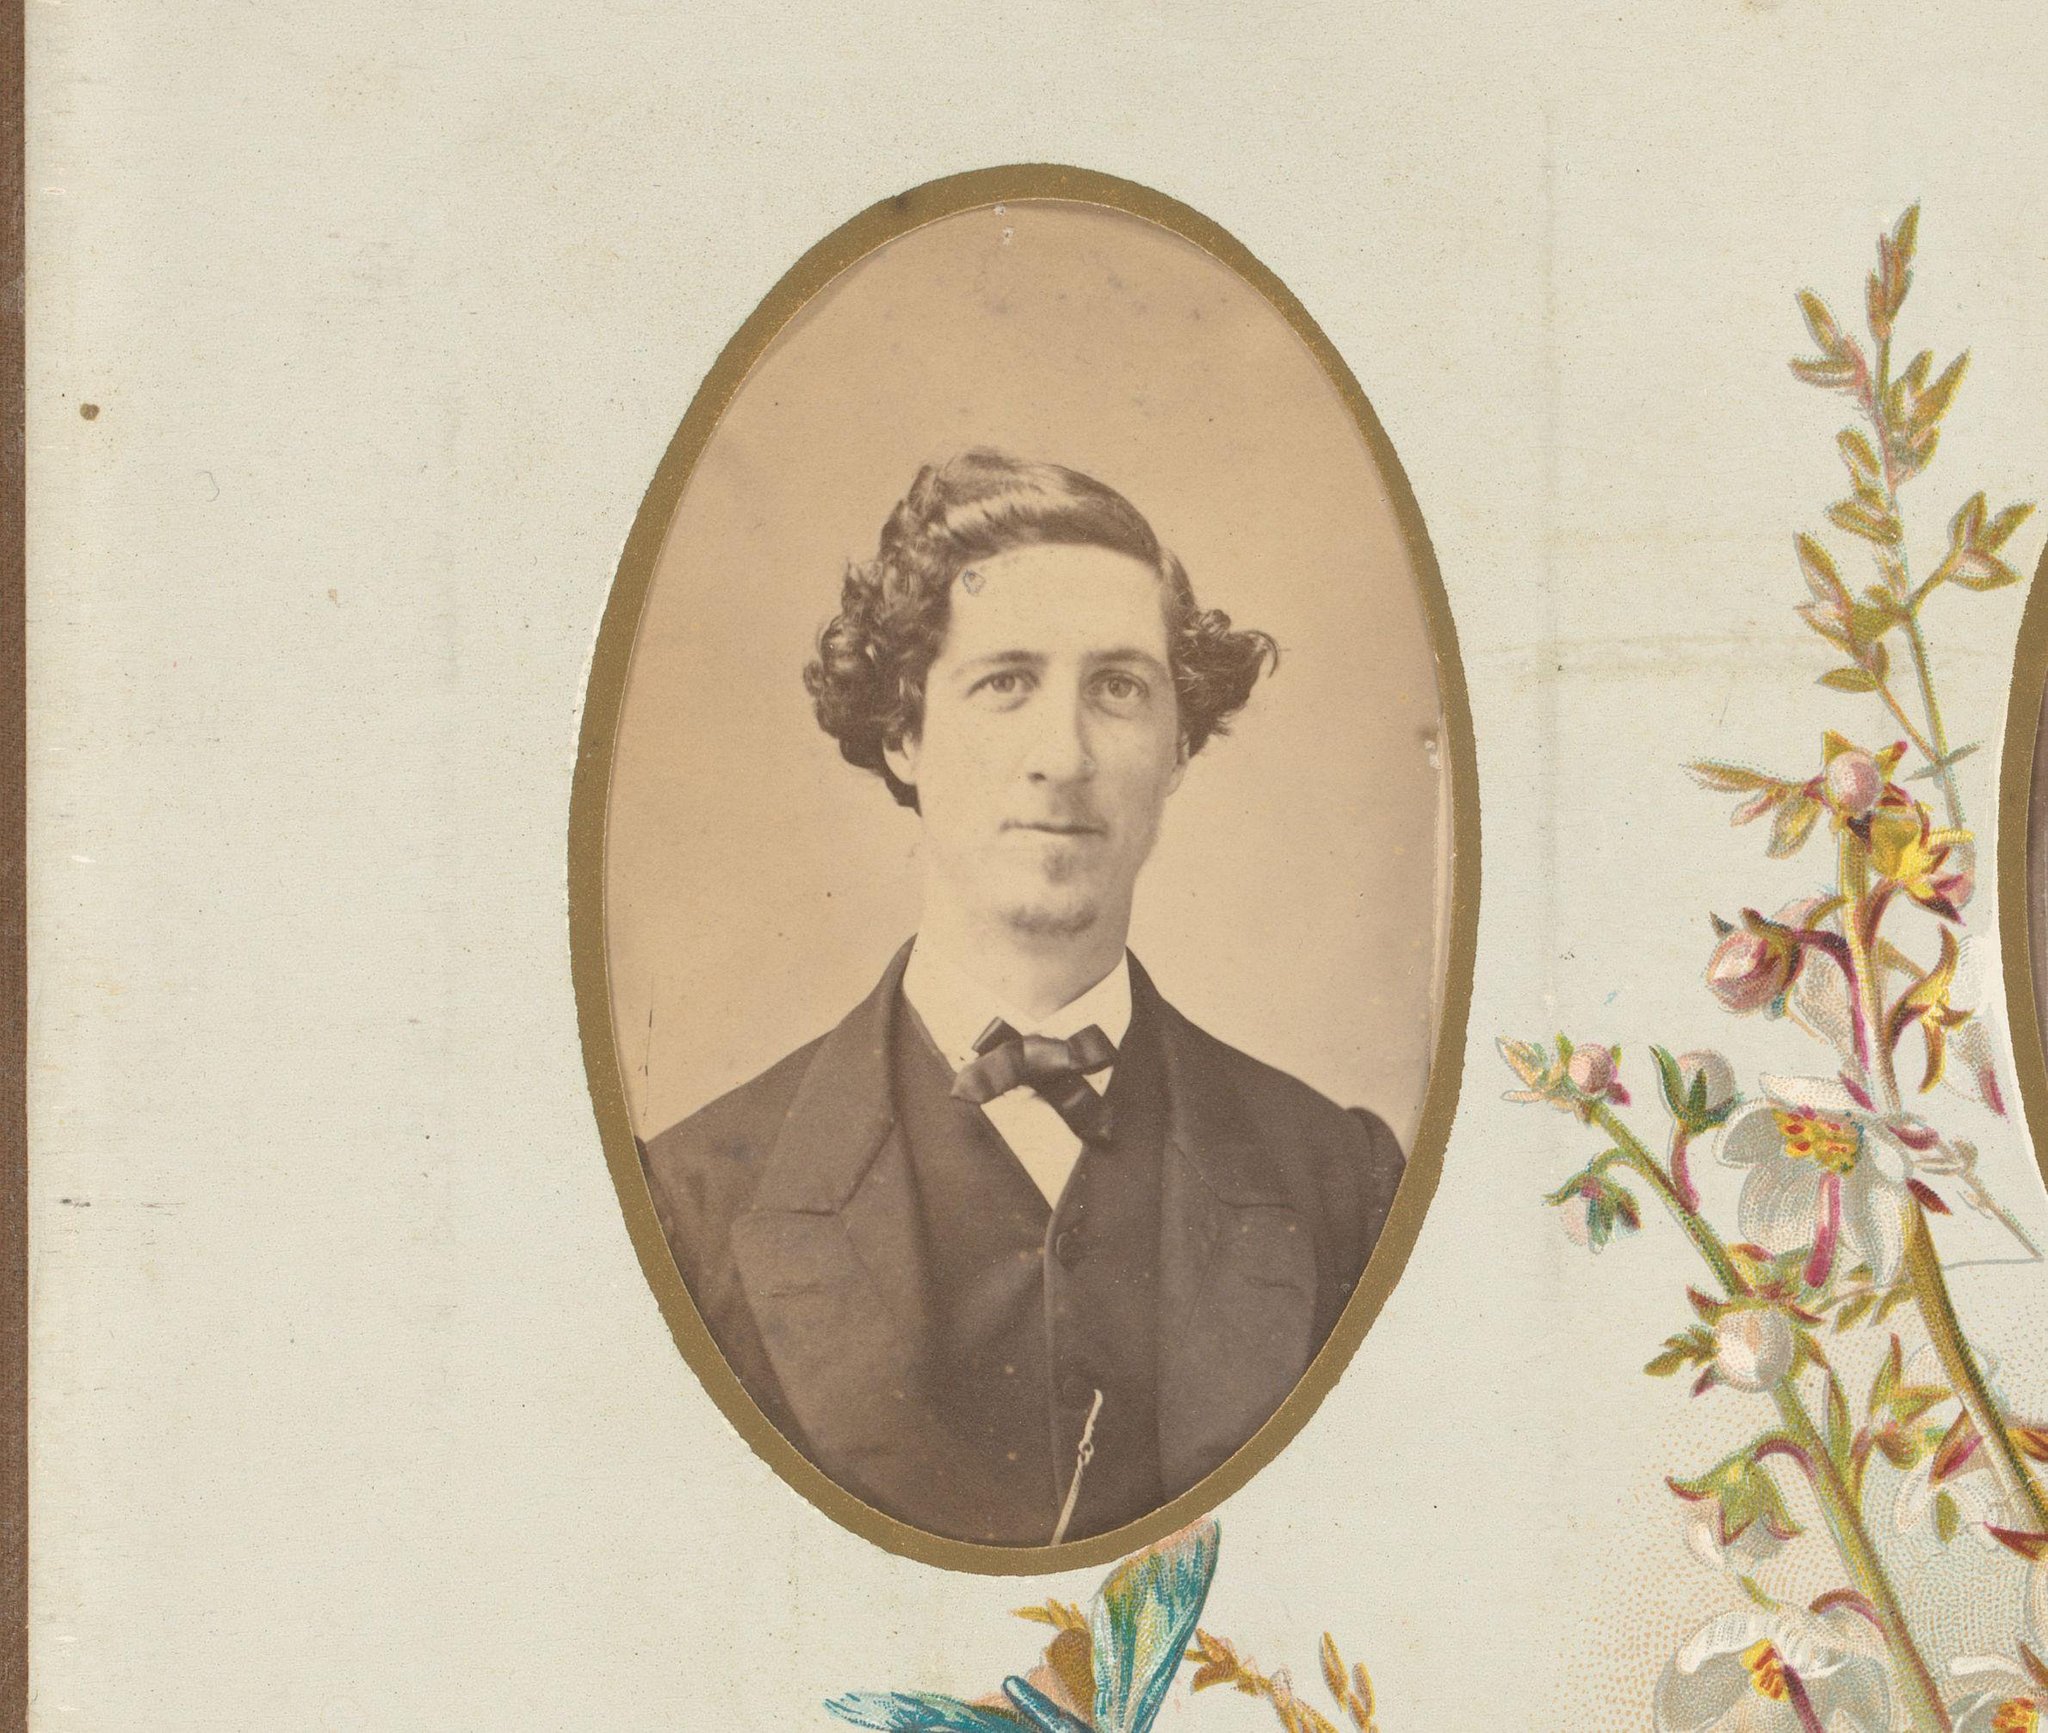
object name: carte de visite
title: Portret van een man met vlinderstrik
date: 1860-1900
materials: cardboard, photographic support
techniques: albumen print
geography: chicago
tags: historical persons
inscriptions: inscription: ‘LA CHAPELLE & SWEENEY/ PHOTOGRAPHERS./ 77 SOUTH CLARK ST.,/ Opp. Court House,/ CHICAGO, - - ILLINOIS.’